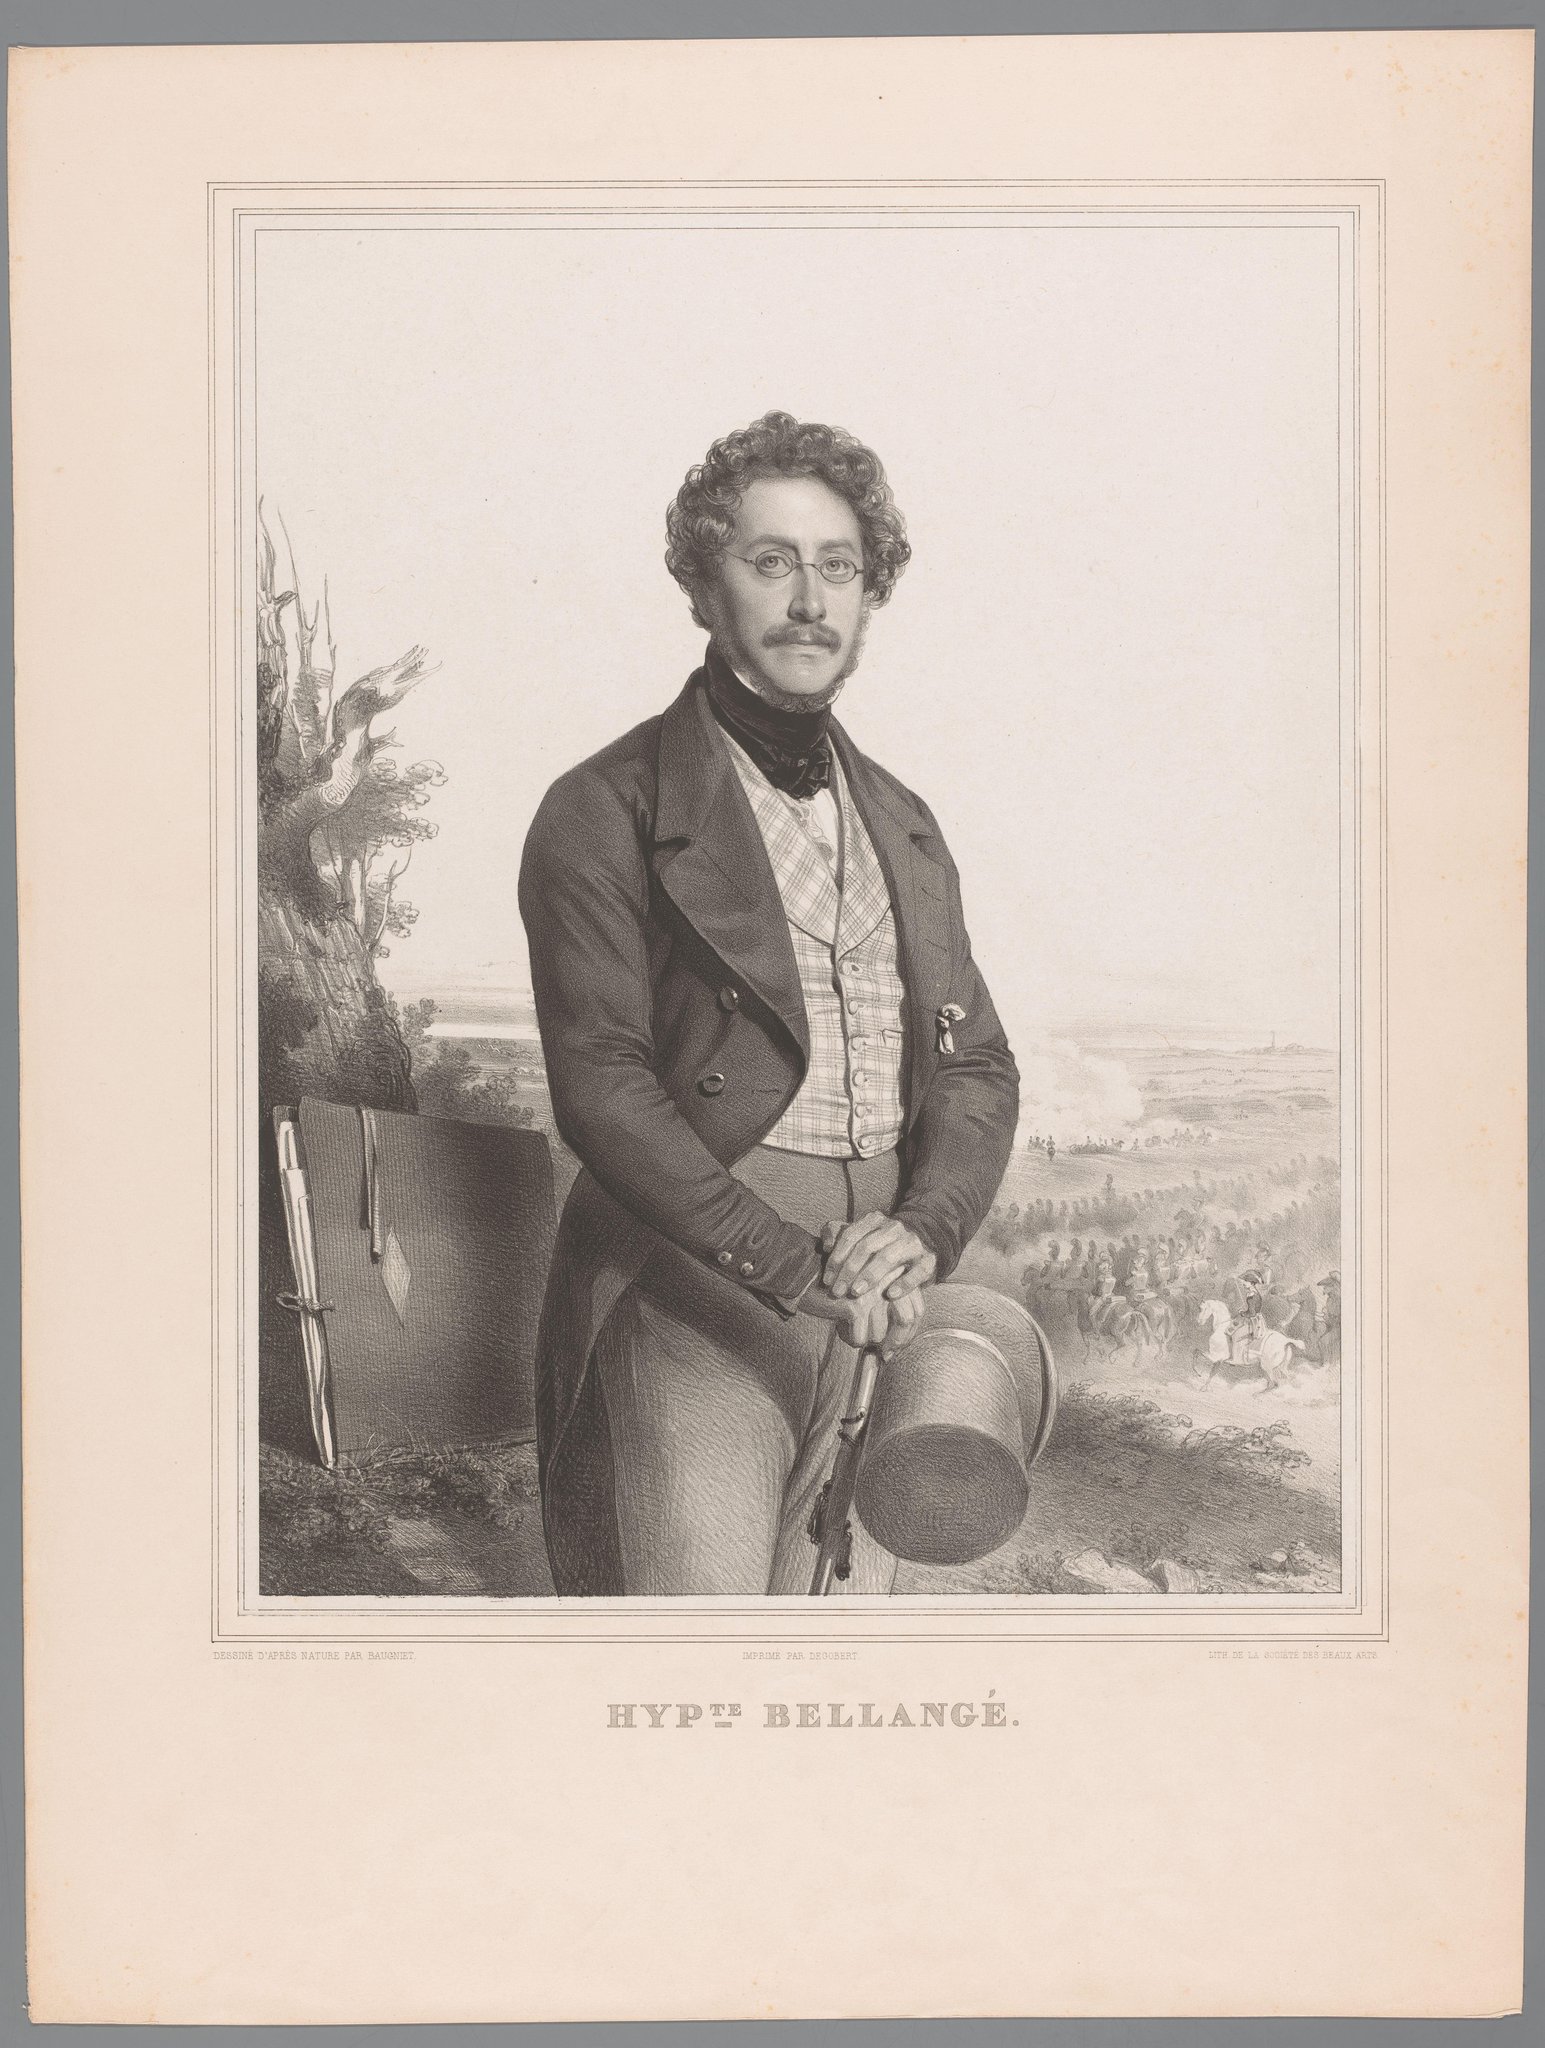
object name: print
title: Hypte Bellangé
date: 1839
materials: paper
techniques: lithograph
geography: brussels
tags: paris, print maker, draughtsman, hippolyte bellangé, eyeglasses, spectacles, adult man, historical persons, battle, head-gear: top hat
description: Prent verschenen in: Baugniet, Charles. Les artistes contemporains: portraits lithographiés d'après nature, accompagnés de notices sur la vie et les ouvrages de chacun d'eux. Brussel: De Wasme-Pletinckx, [1836-1840].